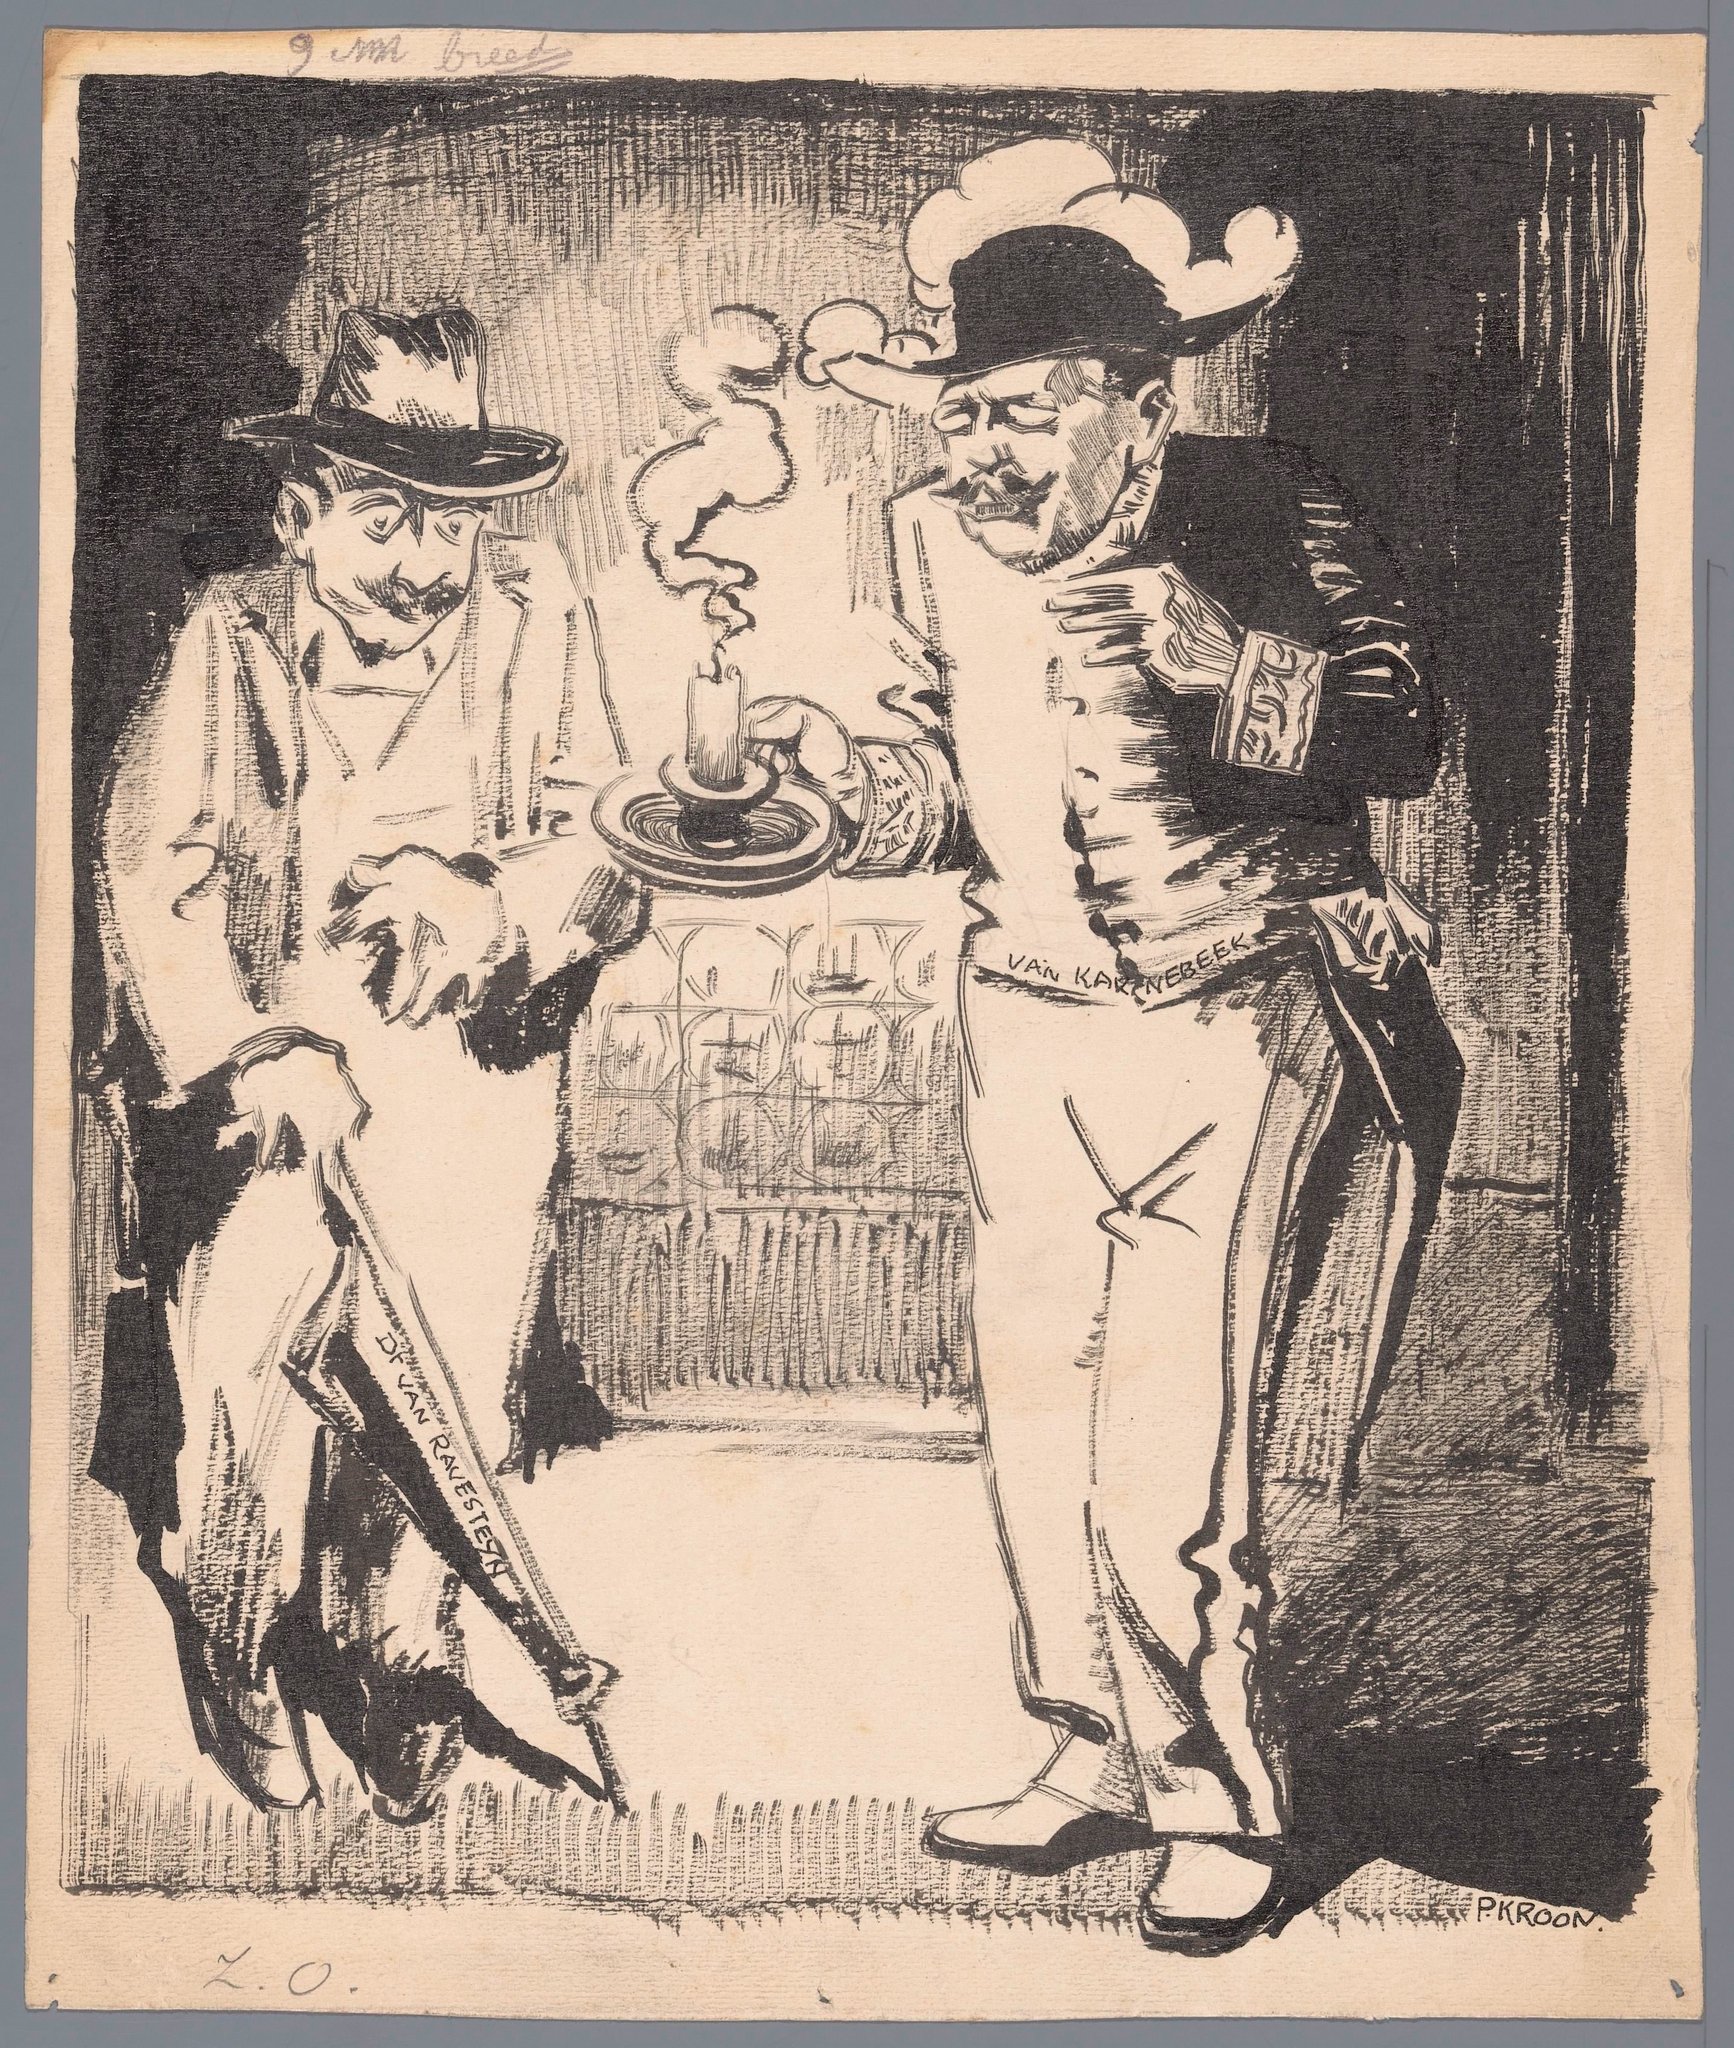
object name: drawing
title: Minister Van Karnebeek en Van Ravesteyn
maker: patricq kroon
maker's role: draughtsman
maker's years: 1862-1941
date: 1915-1925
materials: paper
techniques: pen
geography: netherlands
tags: rotterdam, candle, political caricatures and satires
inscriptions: inscription: ‘Buitenlandsche Inlichting. v Ravesteyn interpelleerde over de Buitenlandsche reizen van Mr. v. Karnebeek’, number: ‘2990’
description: Minister H.A. van Karnebeek met gedoofde kaars tegenover Willem van Ravesteyn, ca. 1915-1925. Ontwerp voor een politieke spotprent.